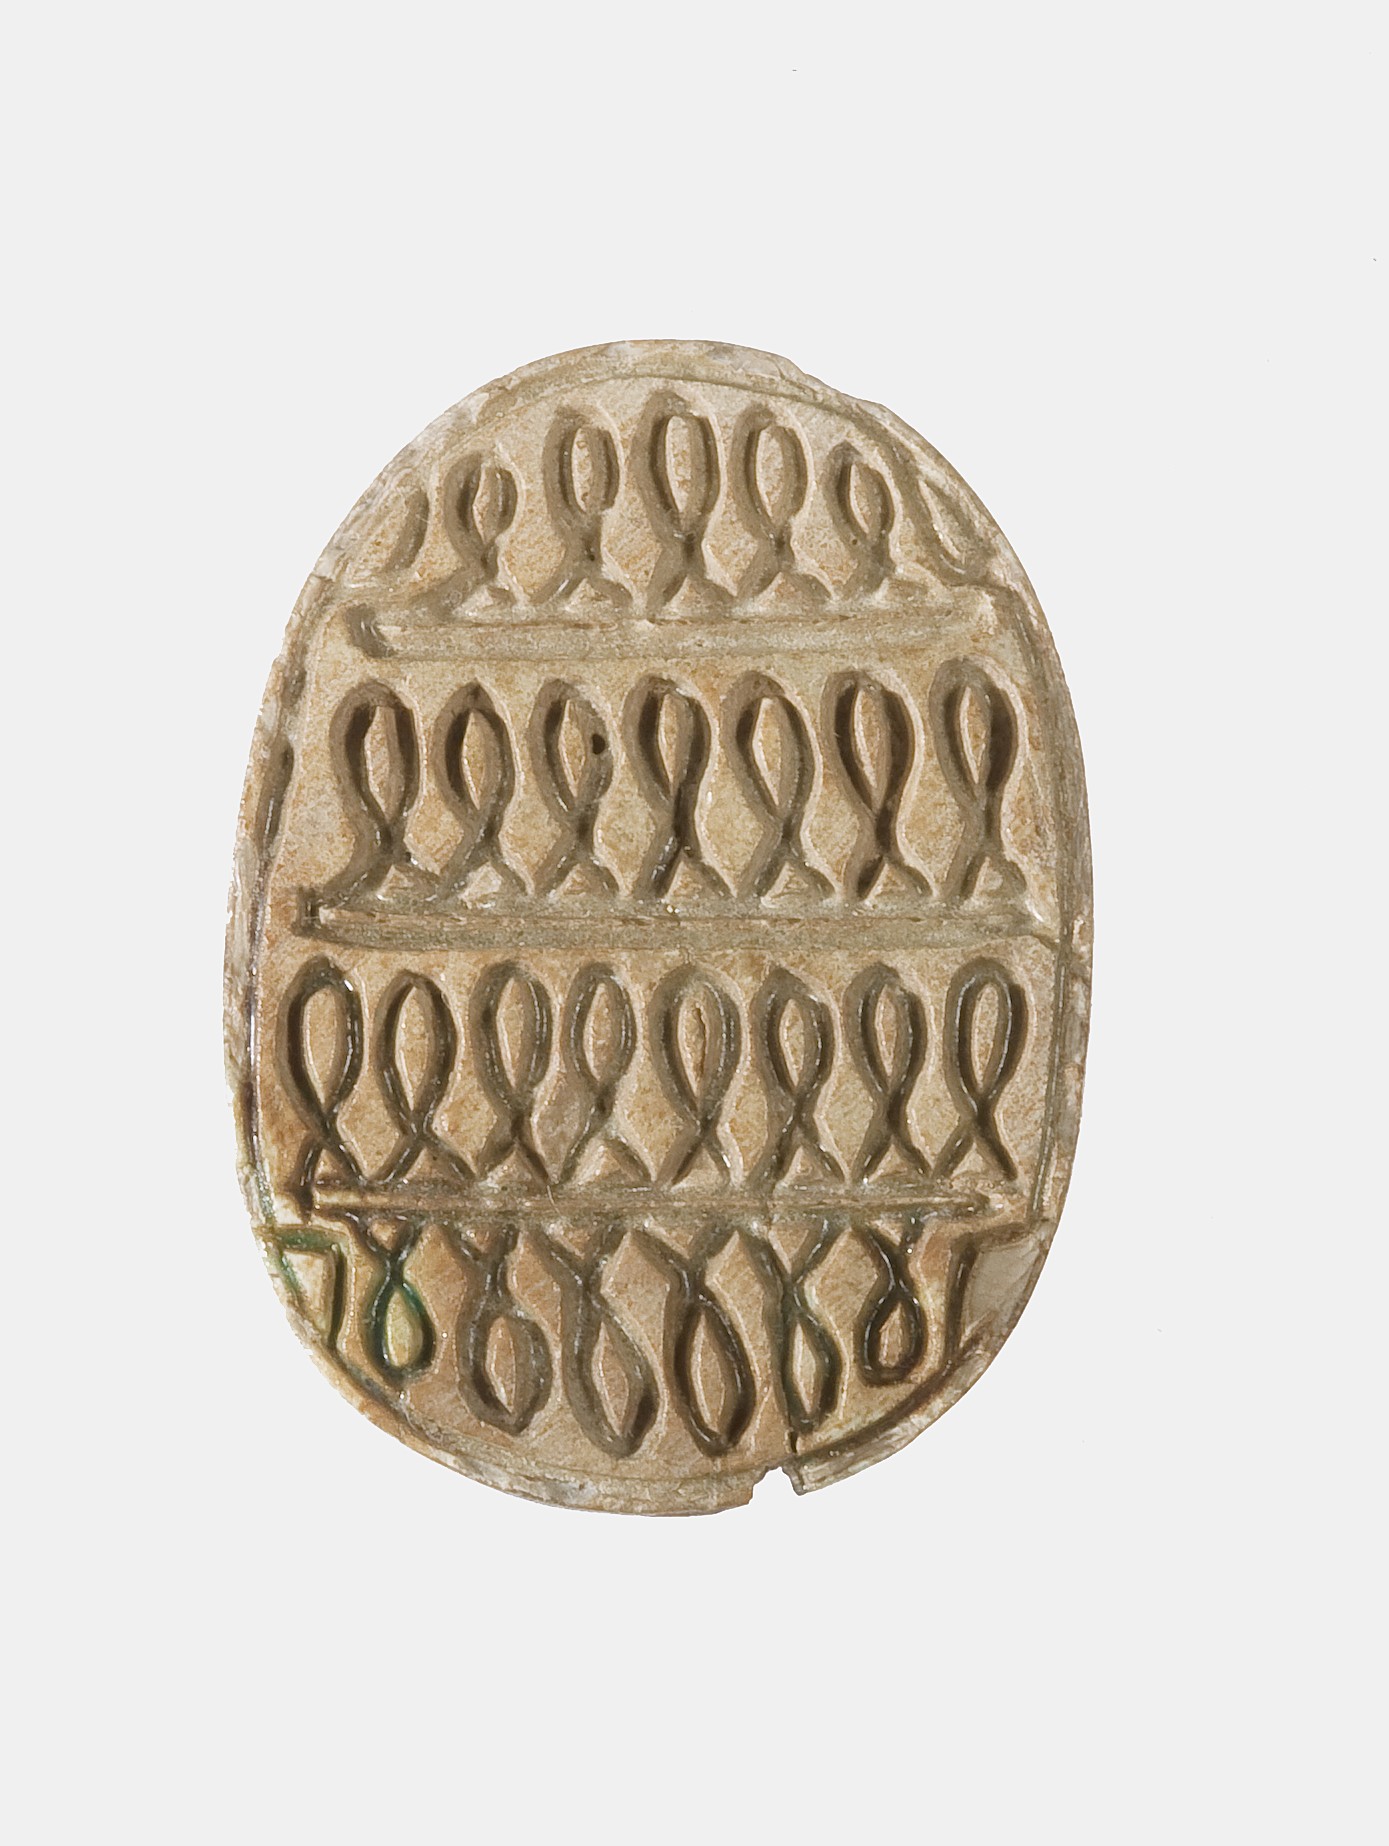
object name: scarab, loop, sa hieroglyph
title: Scarab Decorated with Loops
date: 1770-1670 BCE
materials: glaze, stone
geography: egypt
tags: scarabs